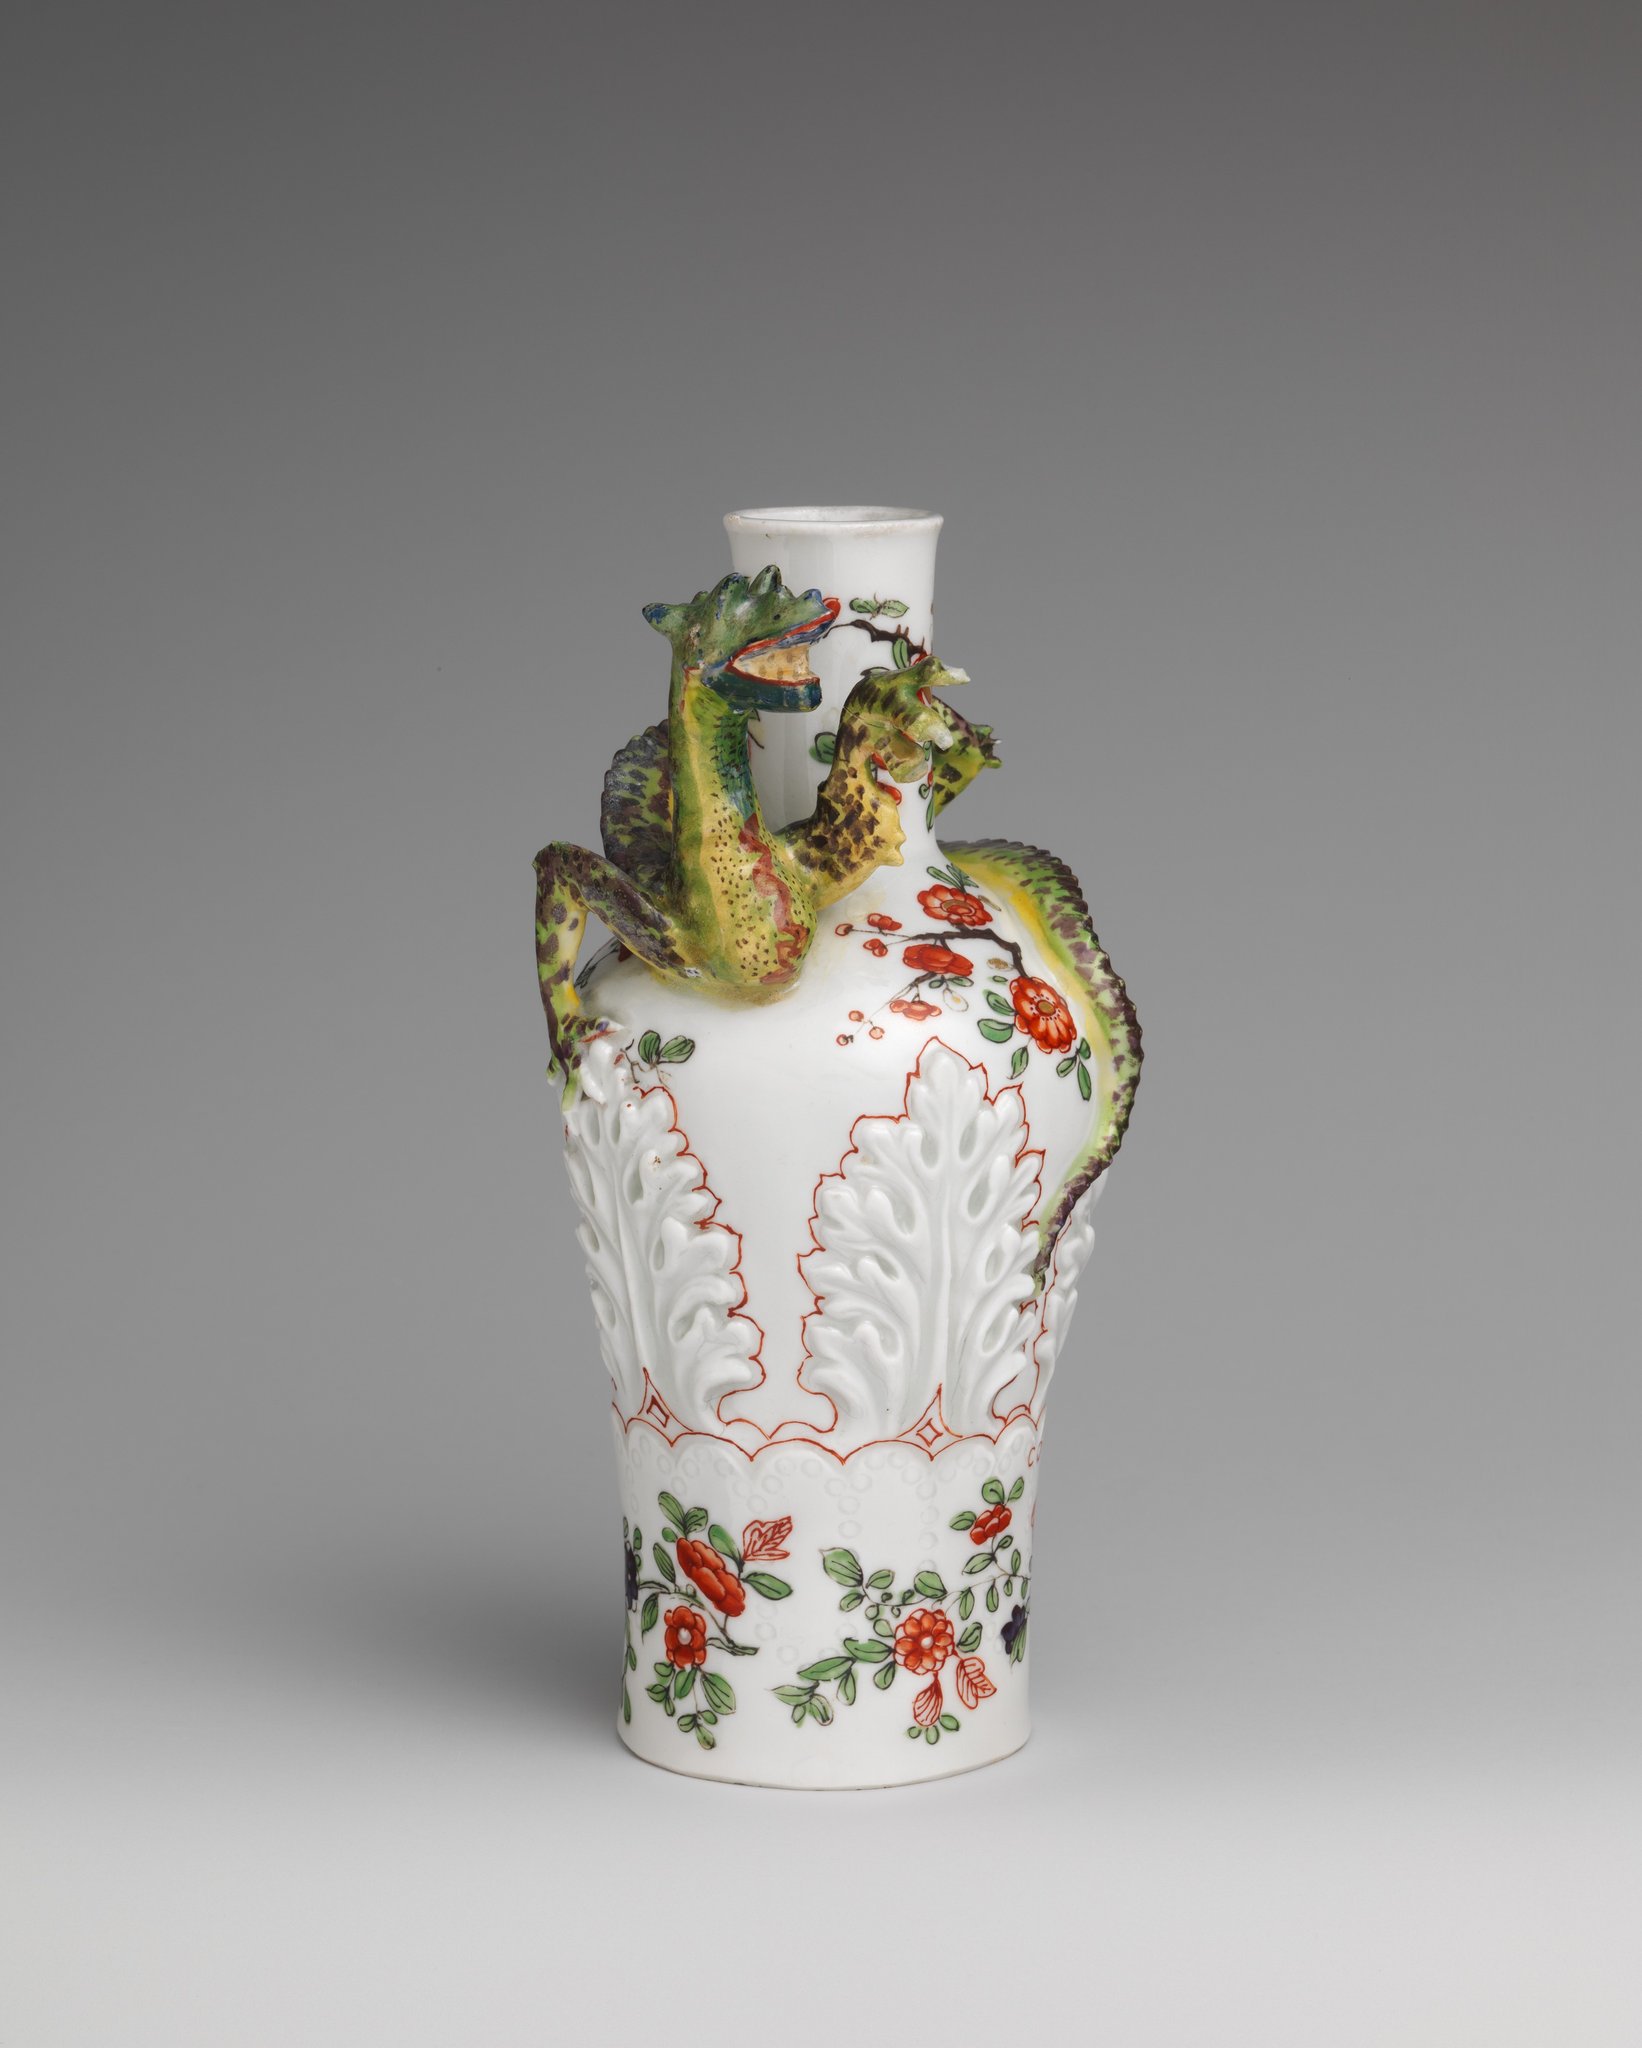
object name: vase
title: Vase with coiling dragon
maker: vienna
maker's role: manufactory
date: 1725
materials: enamel, glaze, hard paste porcelain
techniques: painting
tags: dragons